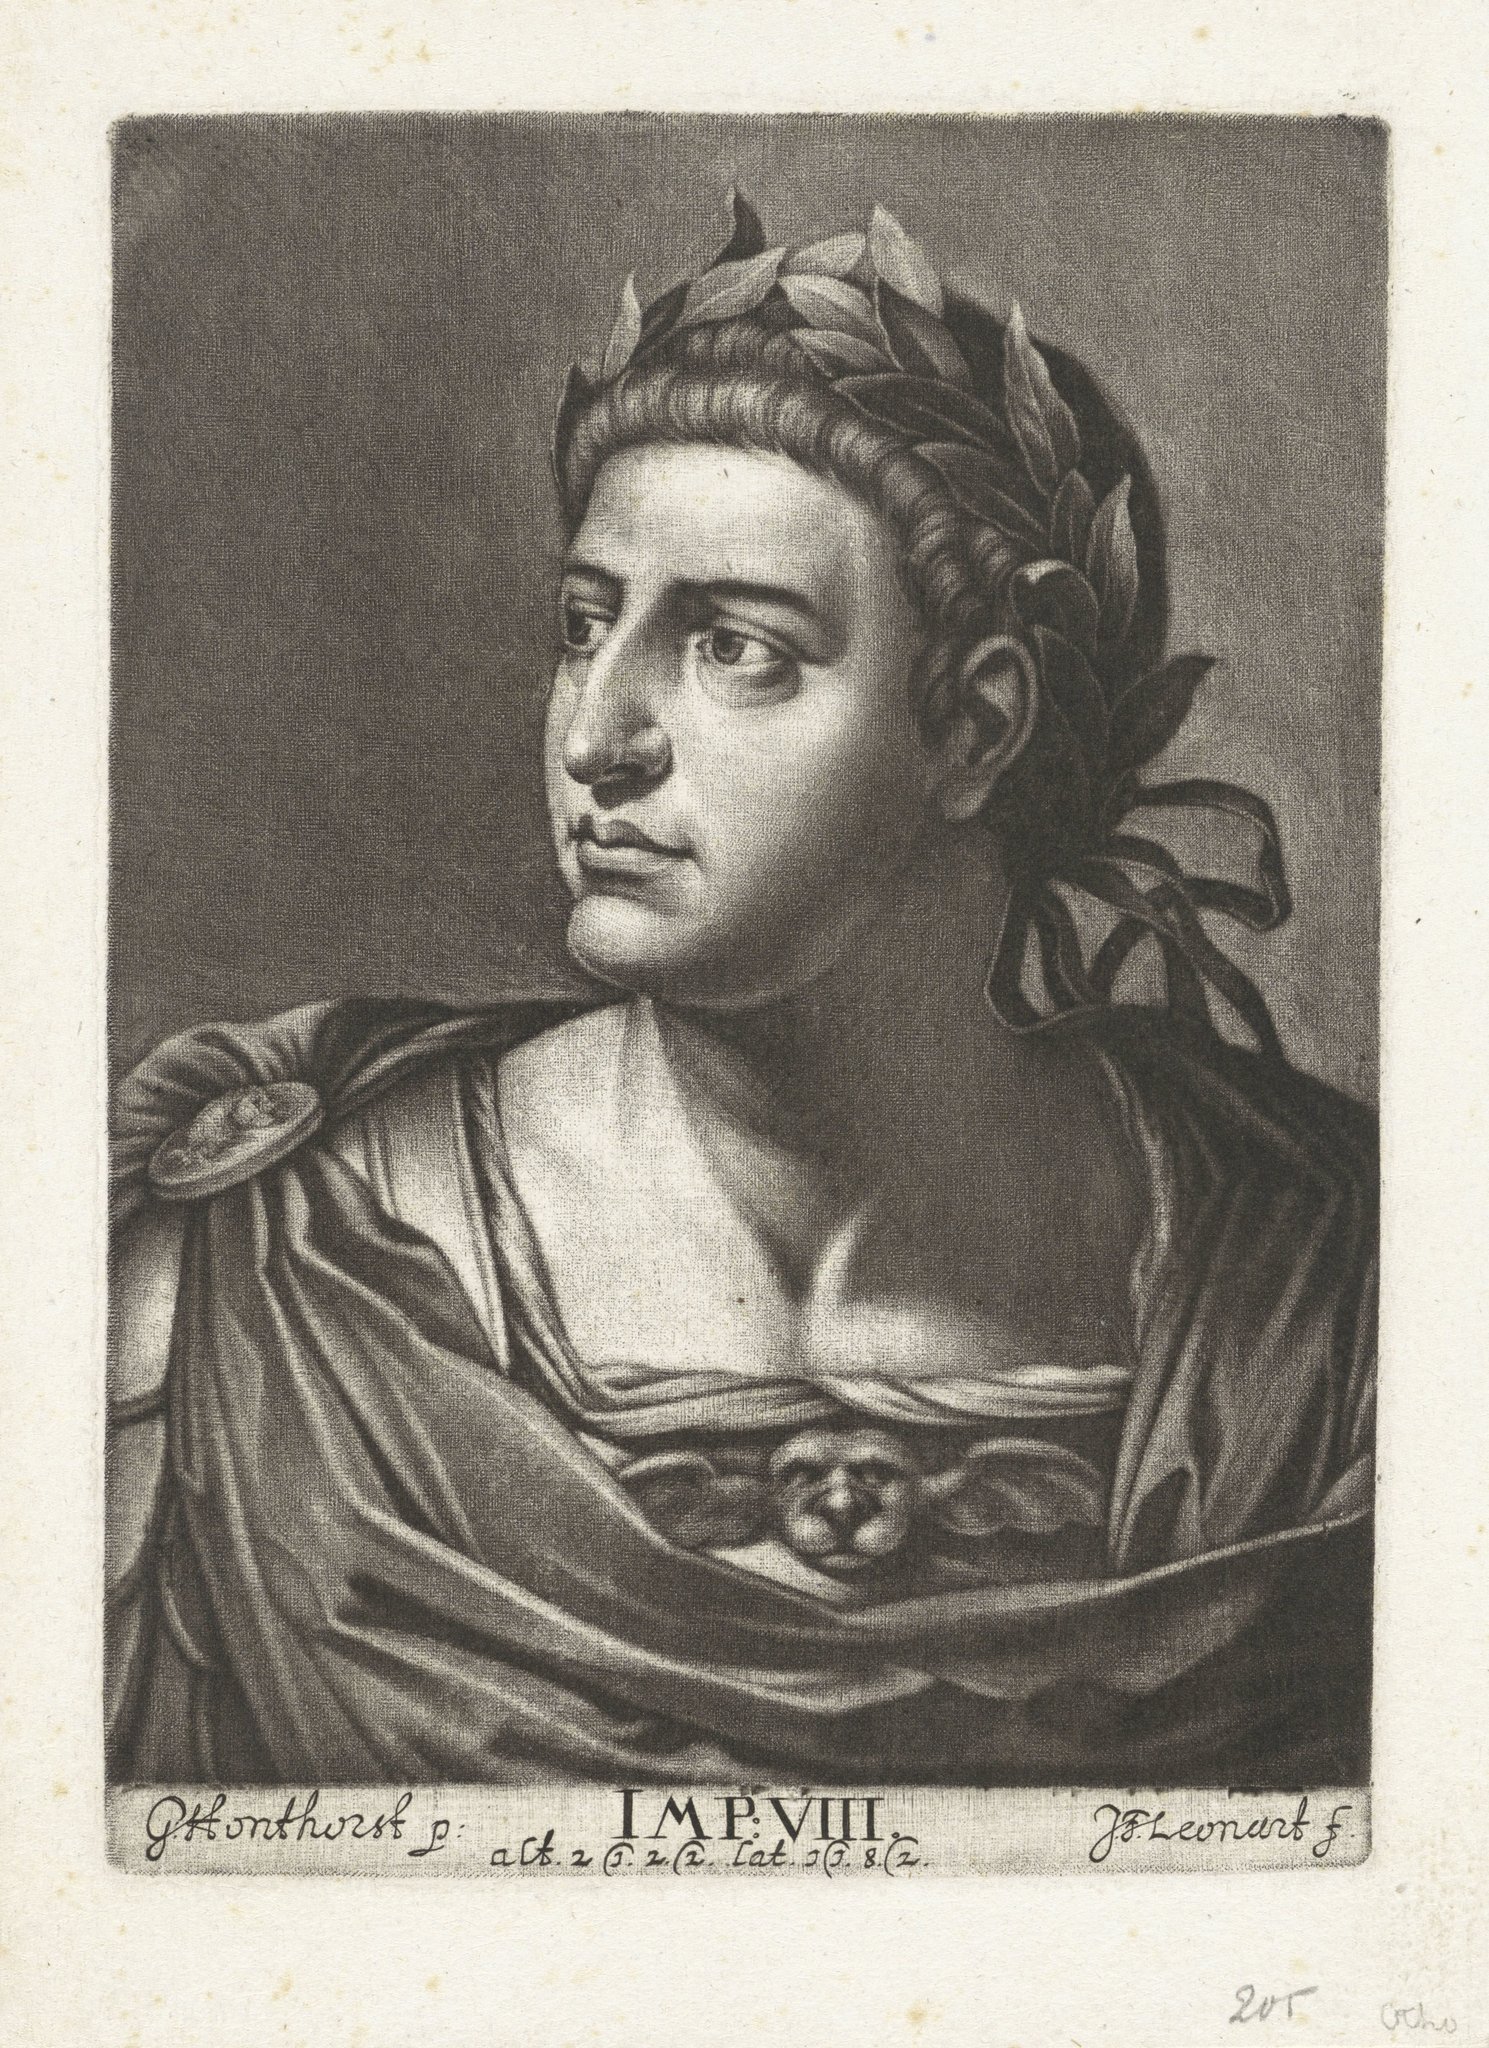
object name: print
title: Romeinse keizers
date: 1643-1680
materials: paper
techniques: engraving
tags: ferento, brescello, keizer, otho (keizer van het romeinse rijk)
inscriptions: collector's mark: Lugt 2166